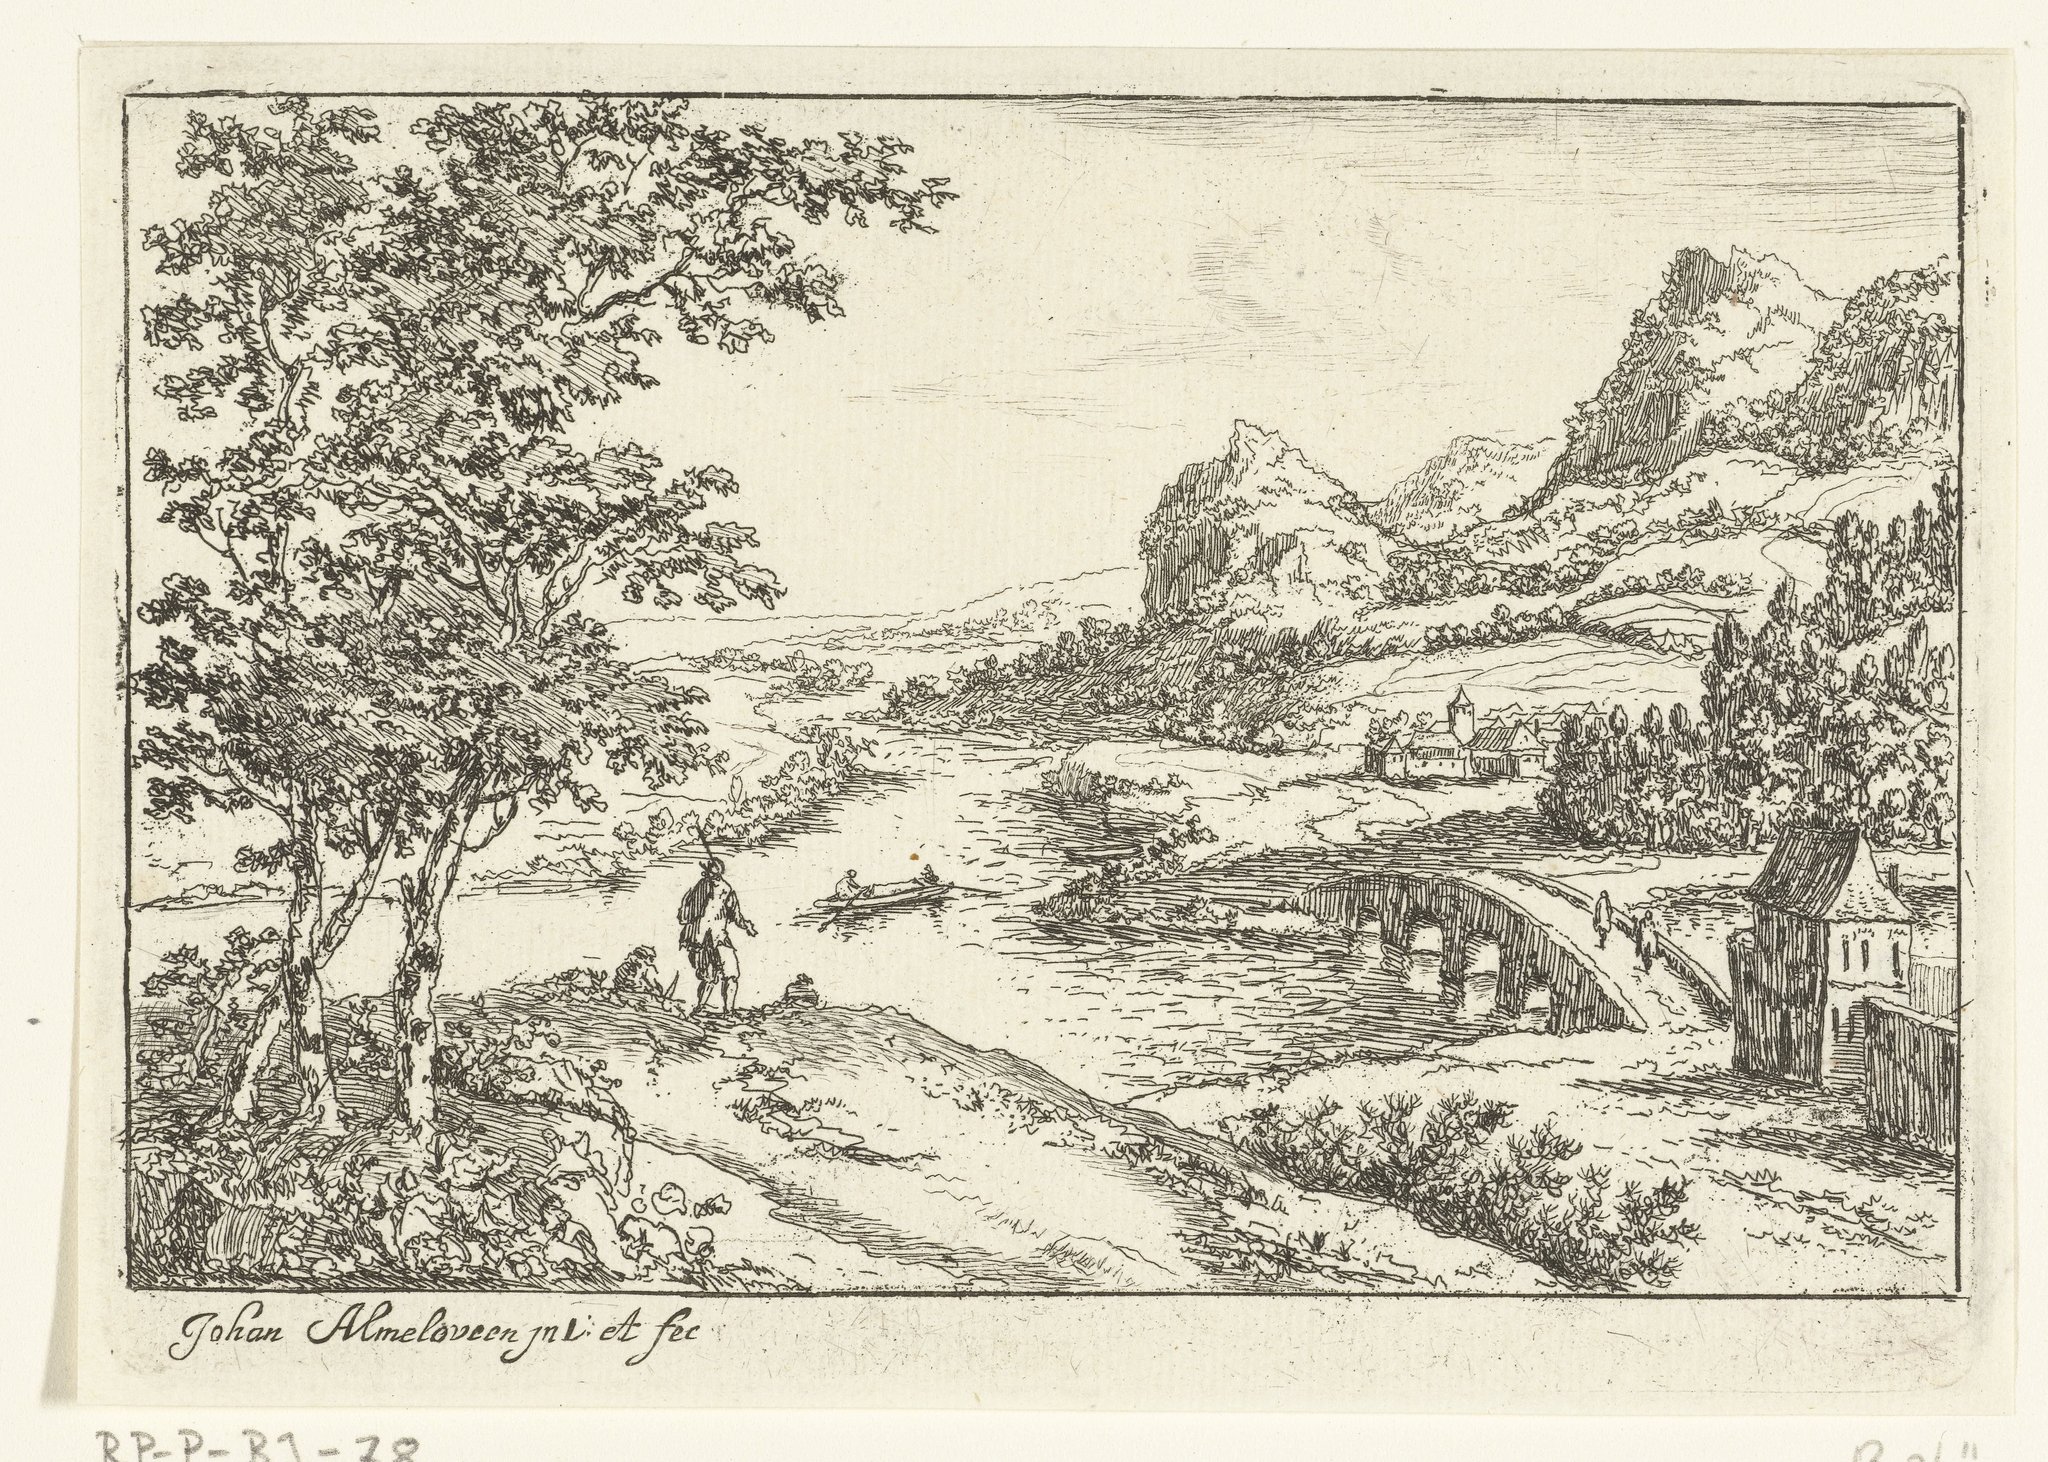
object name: print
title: Vier rivierlandschappen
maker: jan van almeloveen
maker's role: draughtsman, print maker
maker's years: 1652-1683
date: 1662-1683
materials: paper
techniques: etching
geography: netherlands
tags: river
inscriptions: collector's mark: Lugt 240